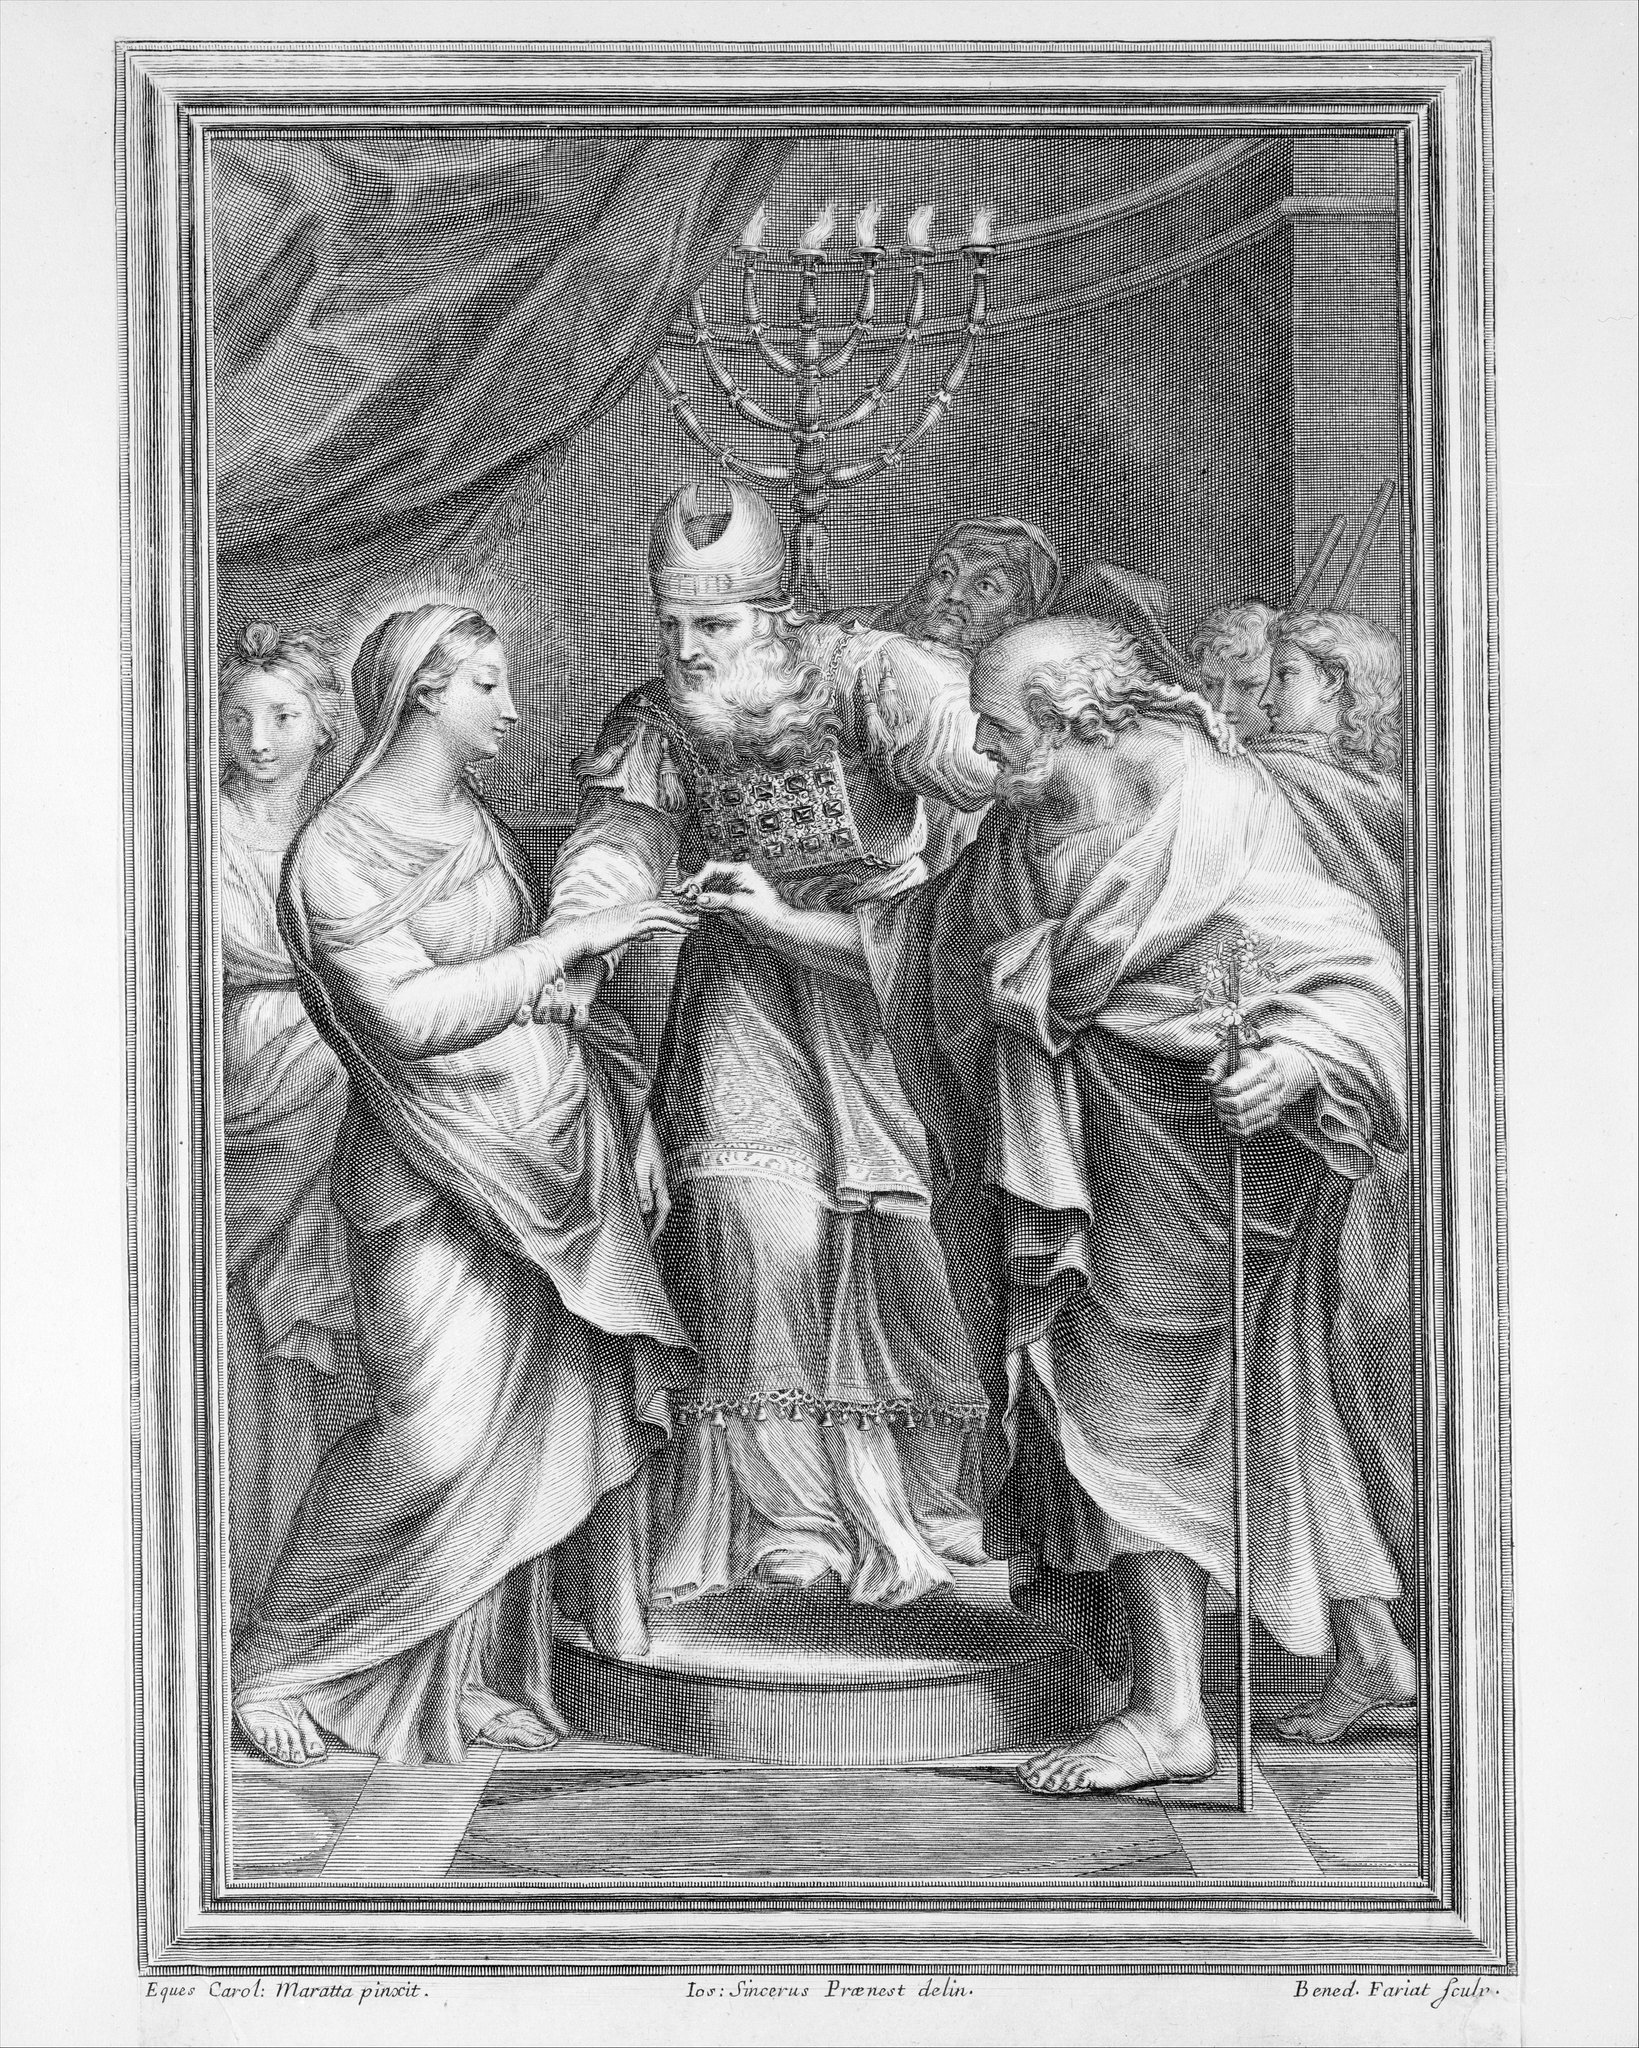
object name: print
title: Marriage of the Virgin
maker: benoit farjat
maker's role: artist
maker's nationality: french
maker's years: 1626-1724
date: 1645-1724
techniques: engraving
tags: women,virgin mary,saints